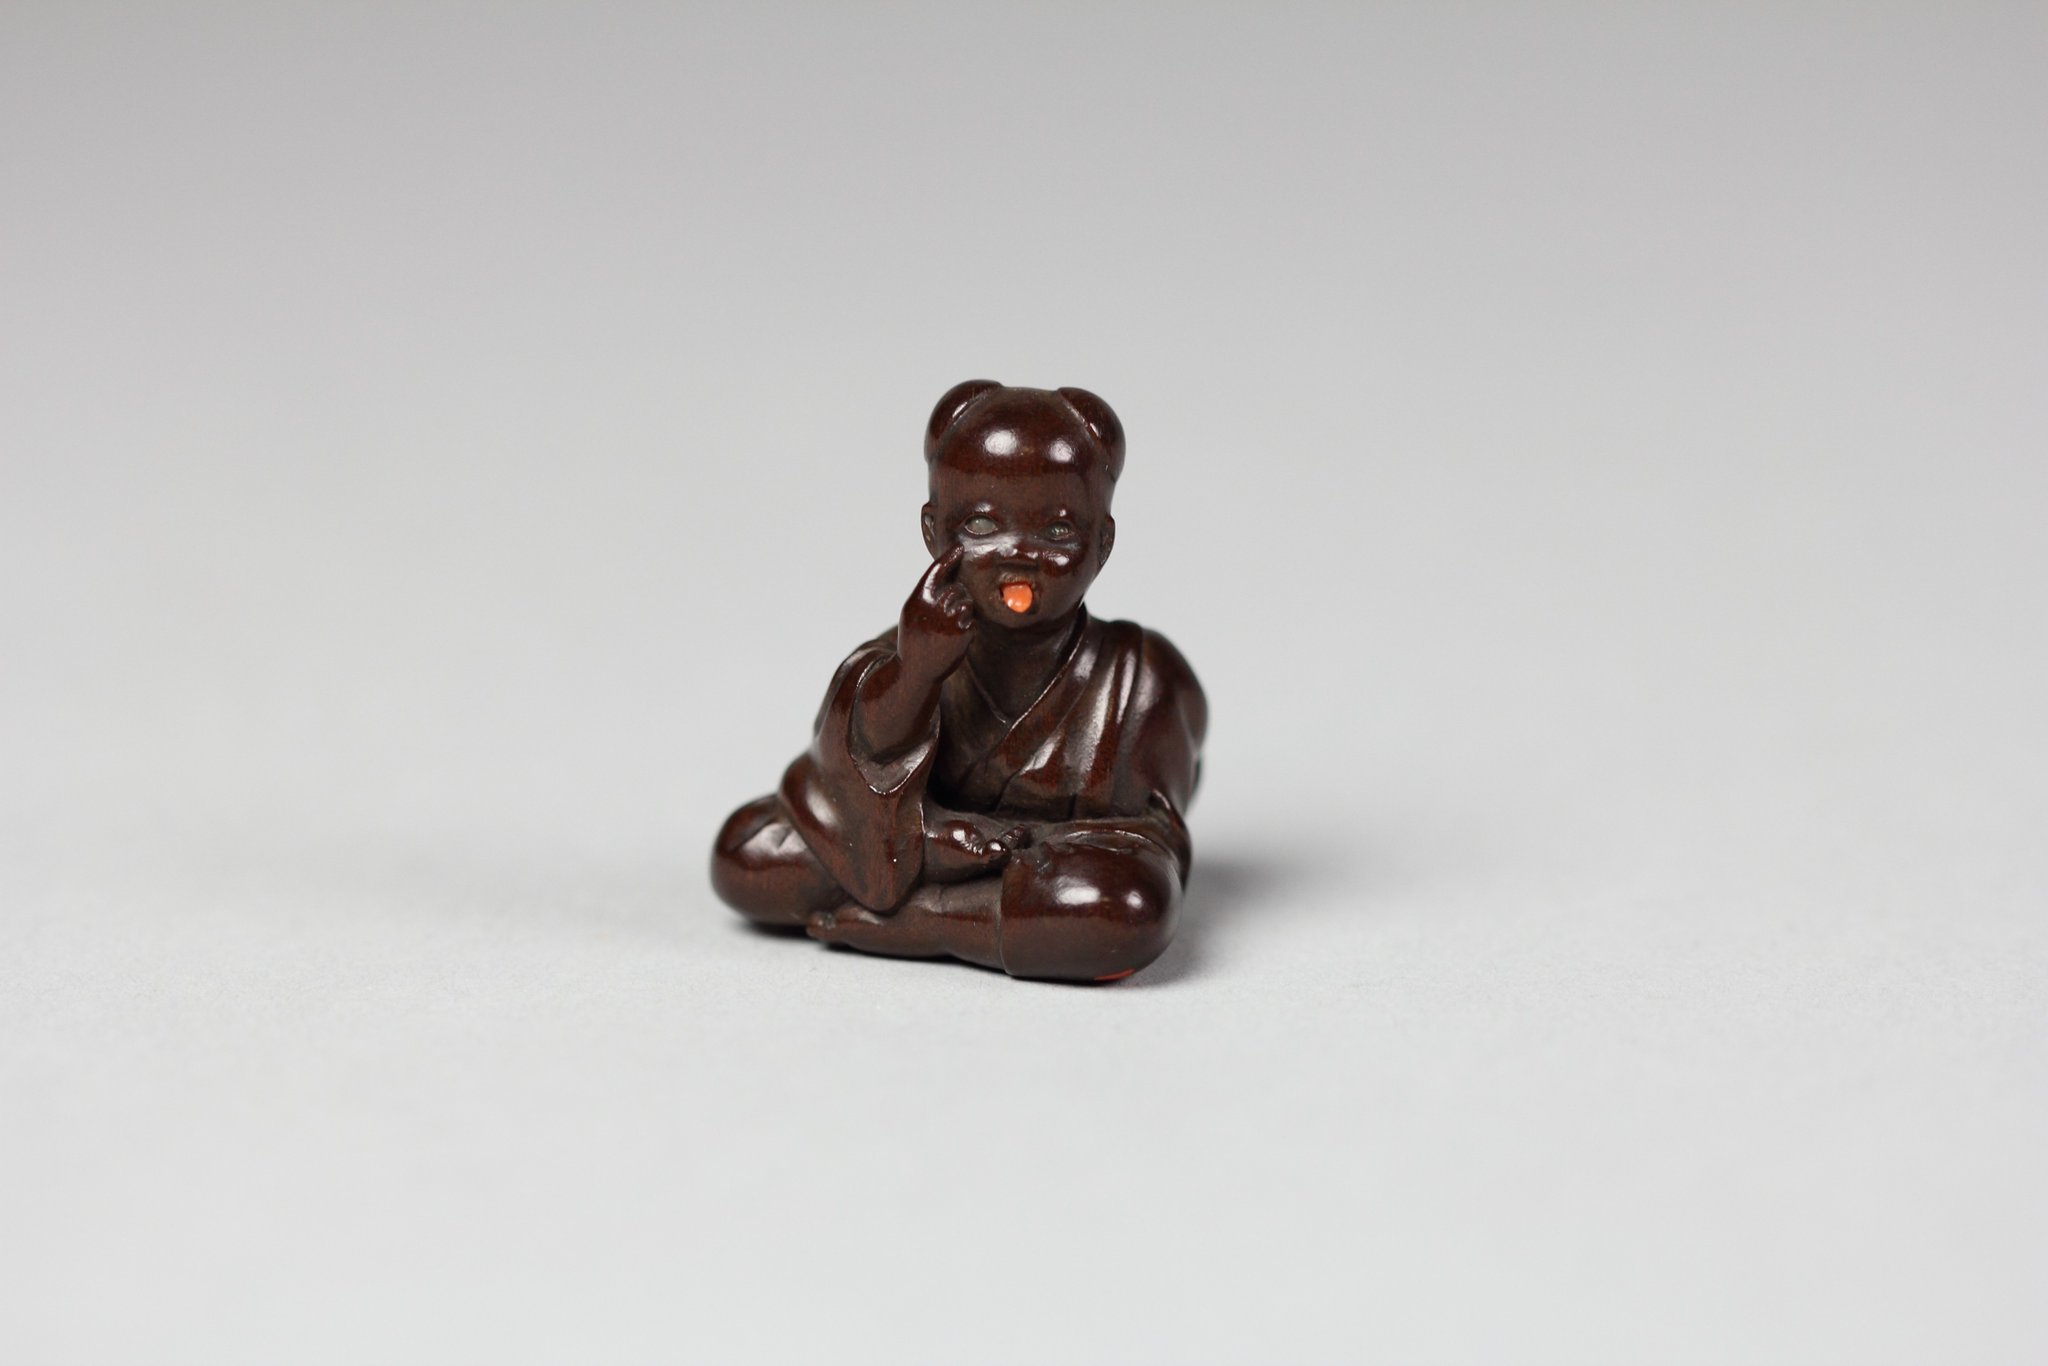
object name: netsuke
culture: japanese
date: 1701-1800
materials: wood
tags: human figures